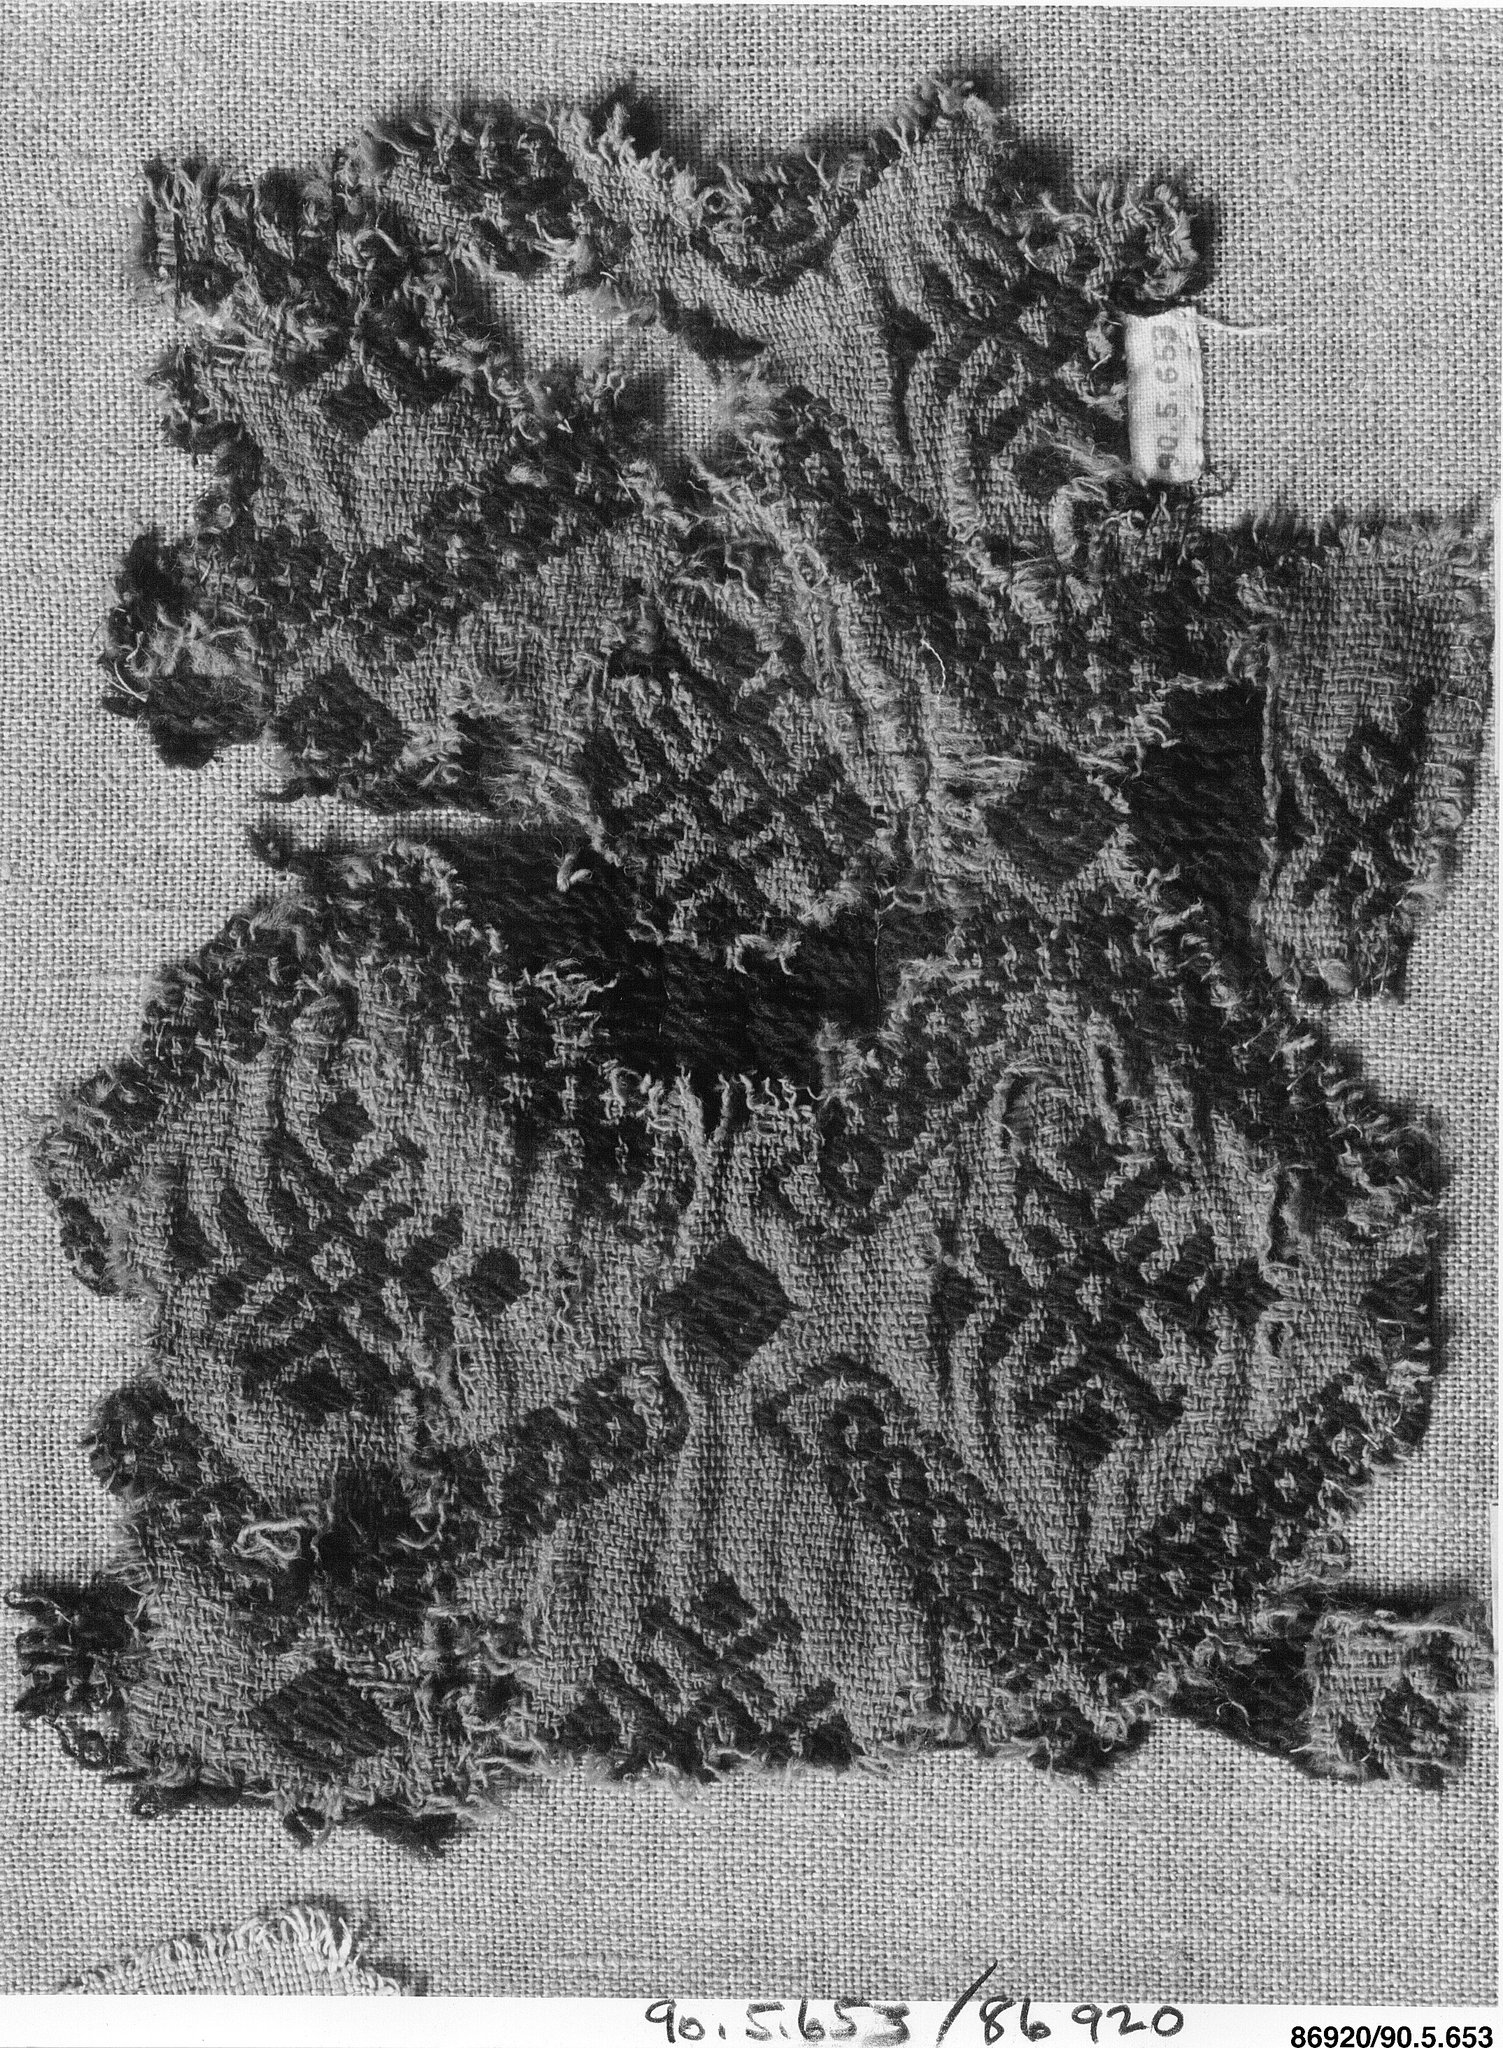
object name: textile fragment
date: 401-600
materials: linen, wool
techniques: weave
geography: egypt